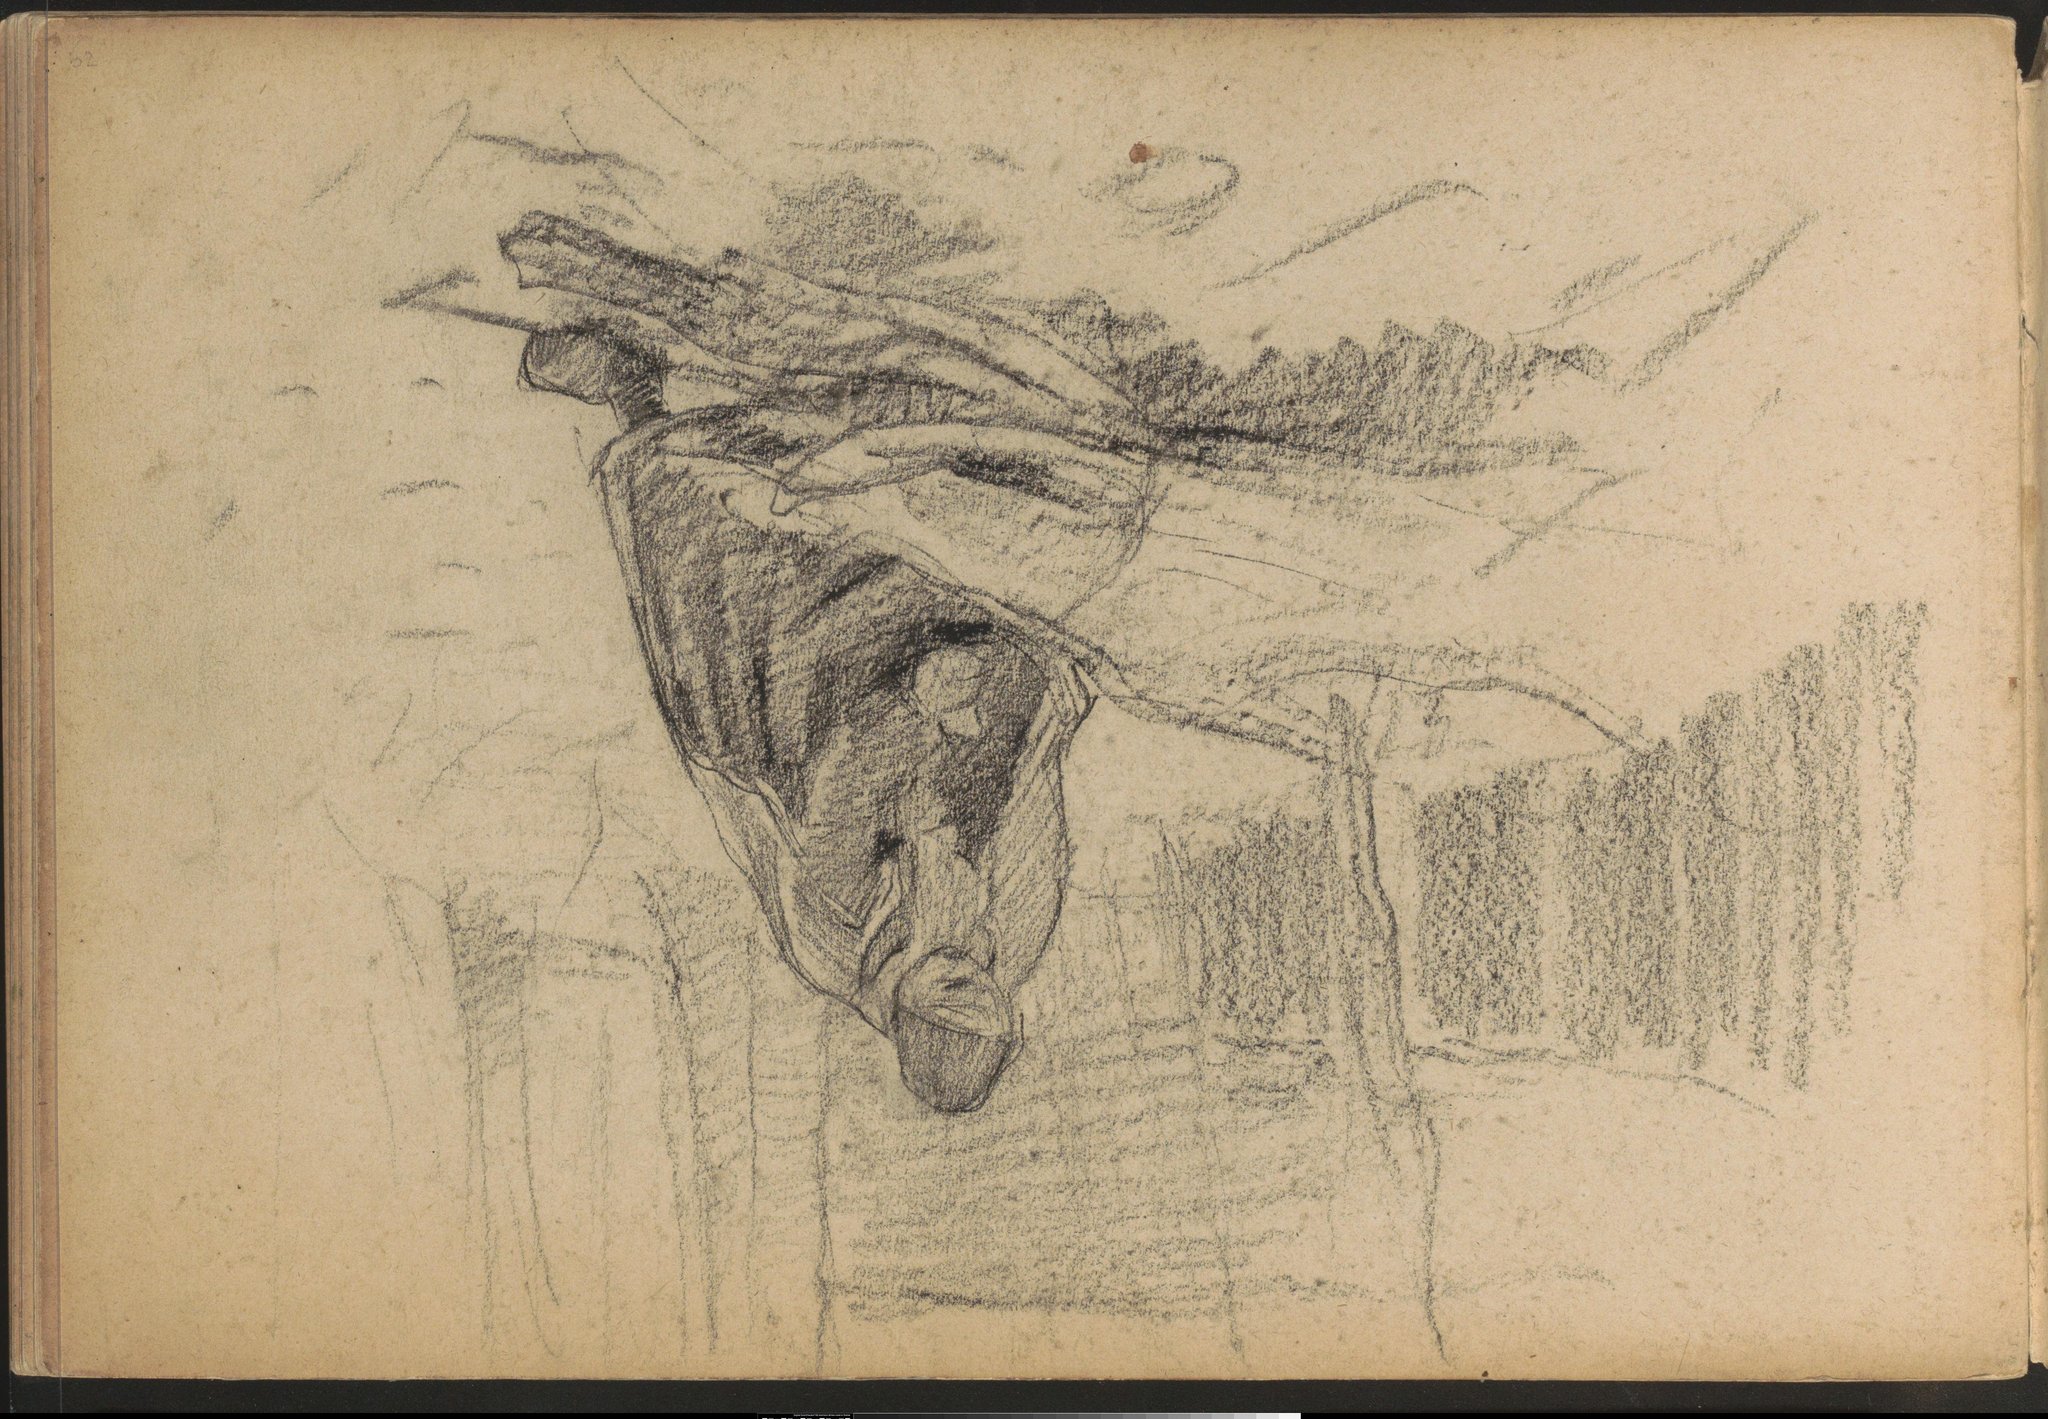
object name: sketchbook leaf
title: Vrouw bindt een bos takken aaneen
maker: willem witsen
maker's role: draughtsman, painter, print maker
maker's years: 1860-1923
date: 1884-1887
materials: chalk, paper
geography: ewijkshoeve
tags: trees (+ bundle of twigs, faggot), adult woman, forest, wood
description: Pagina 62 uit een schetsboek met 29 bladen.